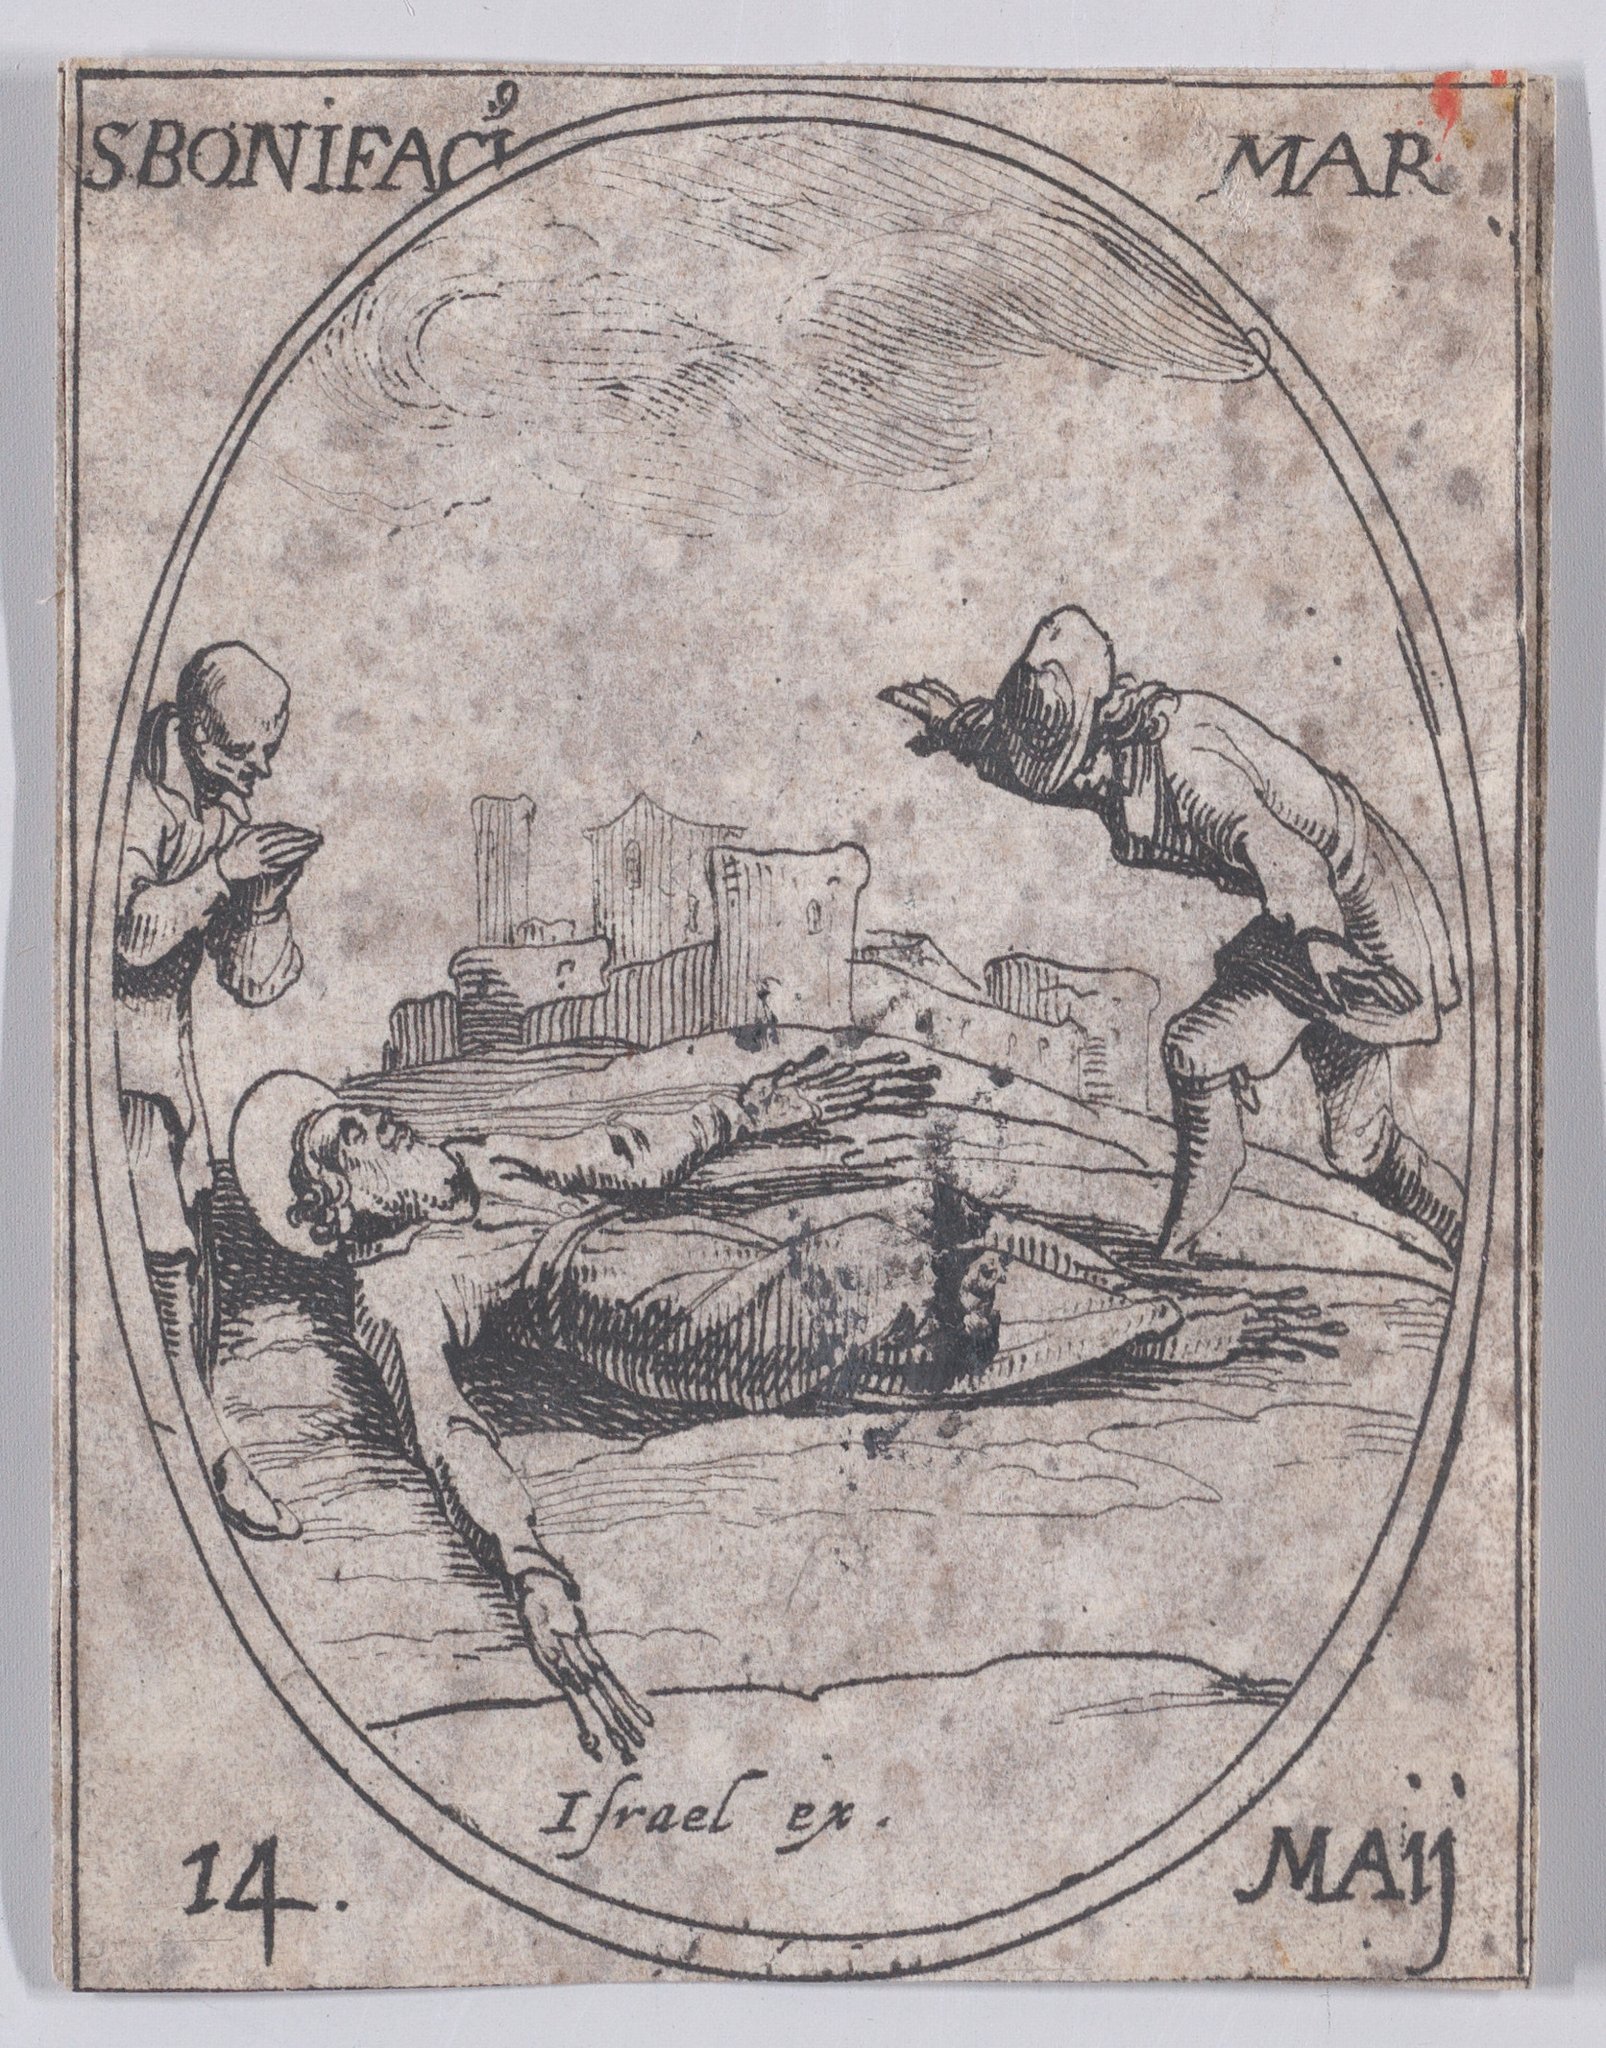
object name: print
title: St. Boniface, Martyr, May 14th, from "Les Images De Tous Les Saincts et Saintes de L'Année" (Images of All of the Saints and Religious Events of the Year)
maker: jacques callot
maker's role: artist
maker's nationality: french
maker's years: 1592-1635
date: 1636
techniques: etching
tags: men,saints